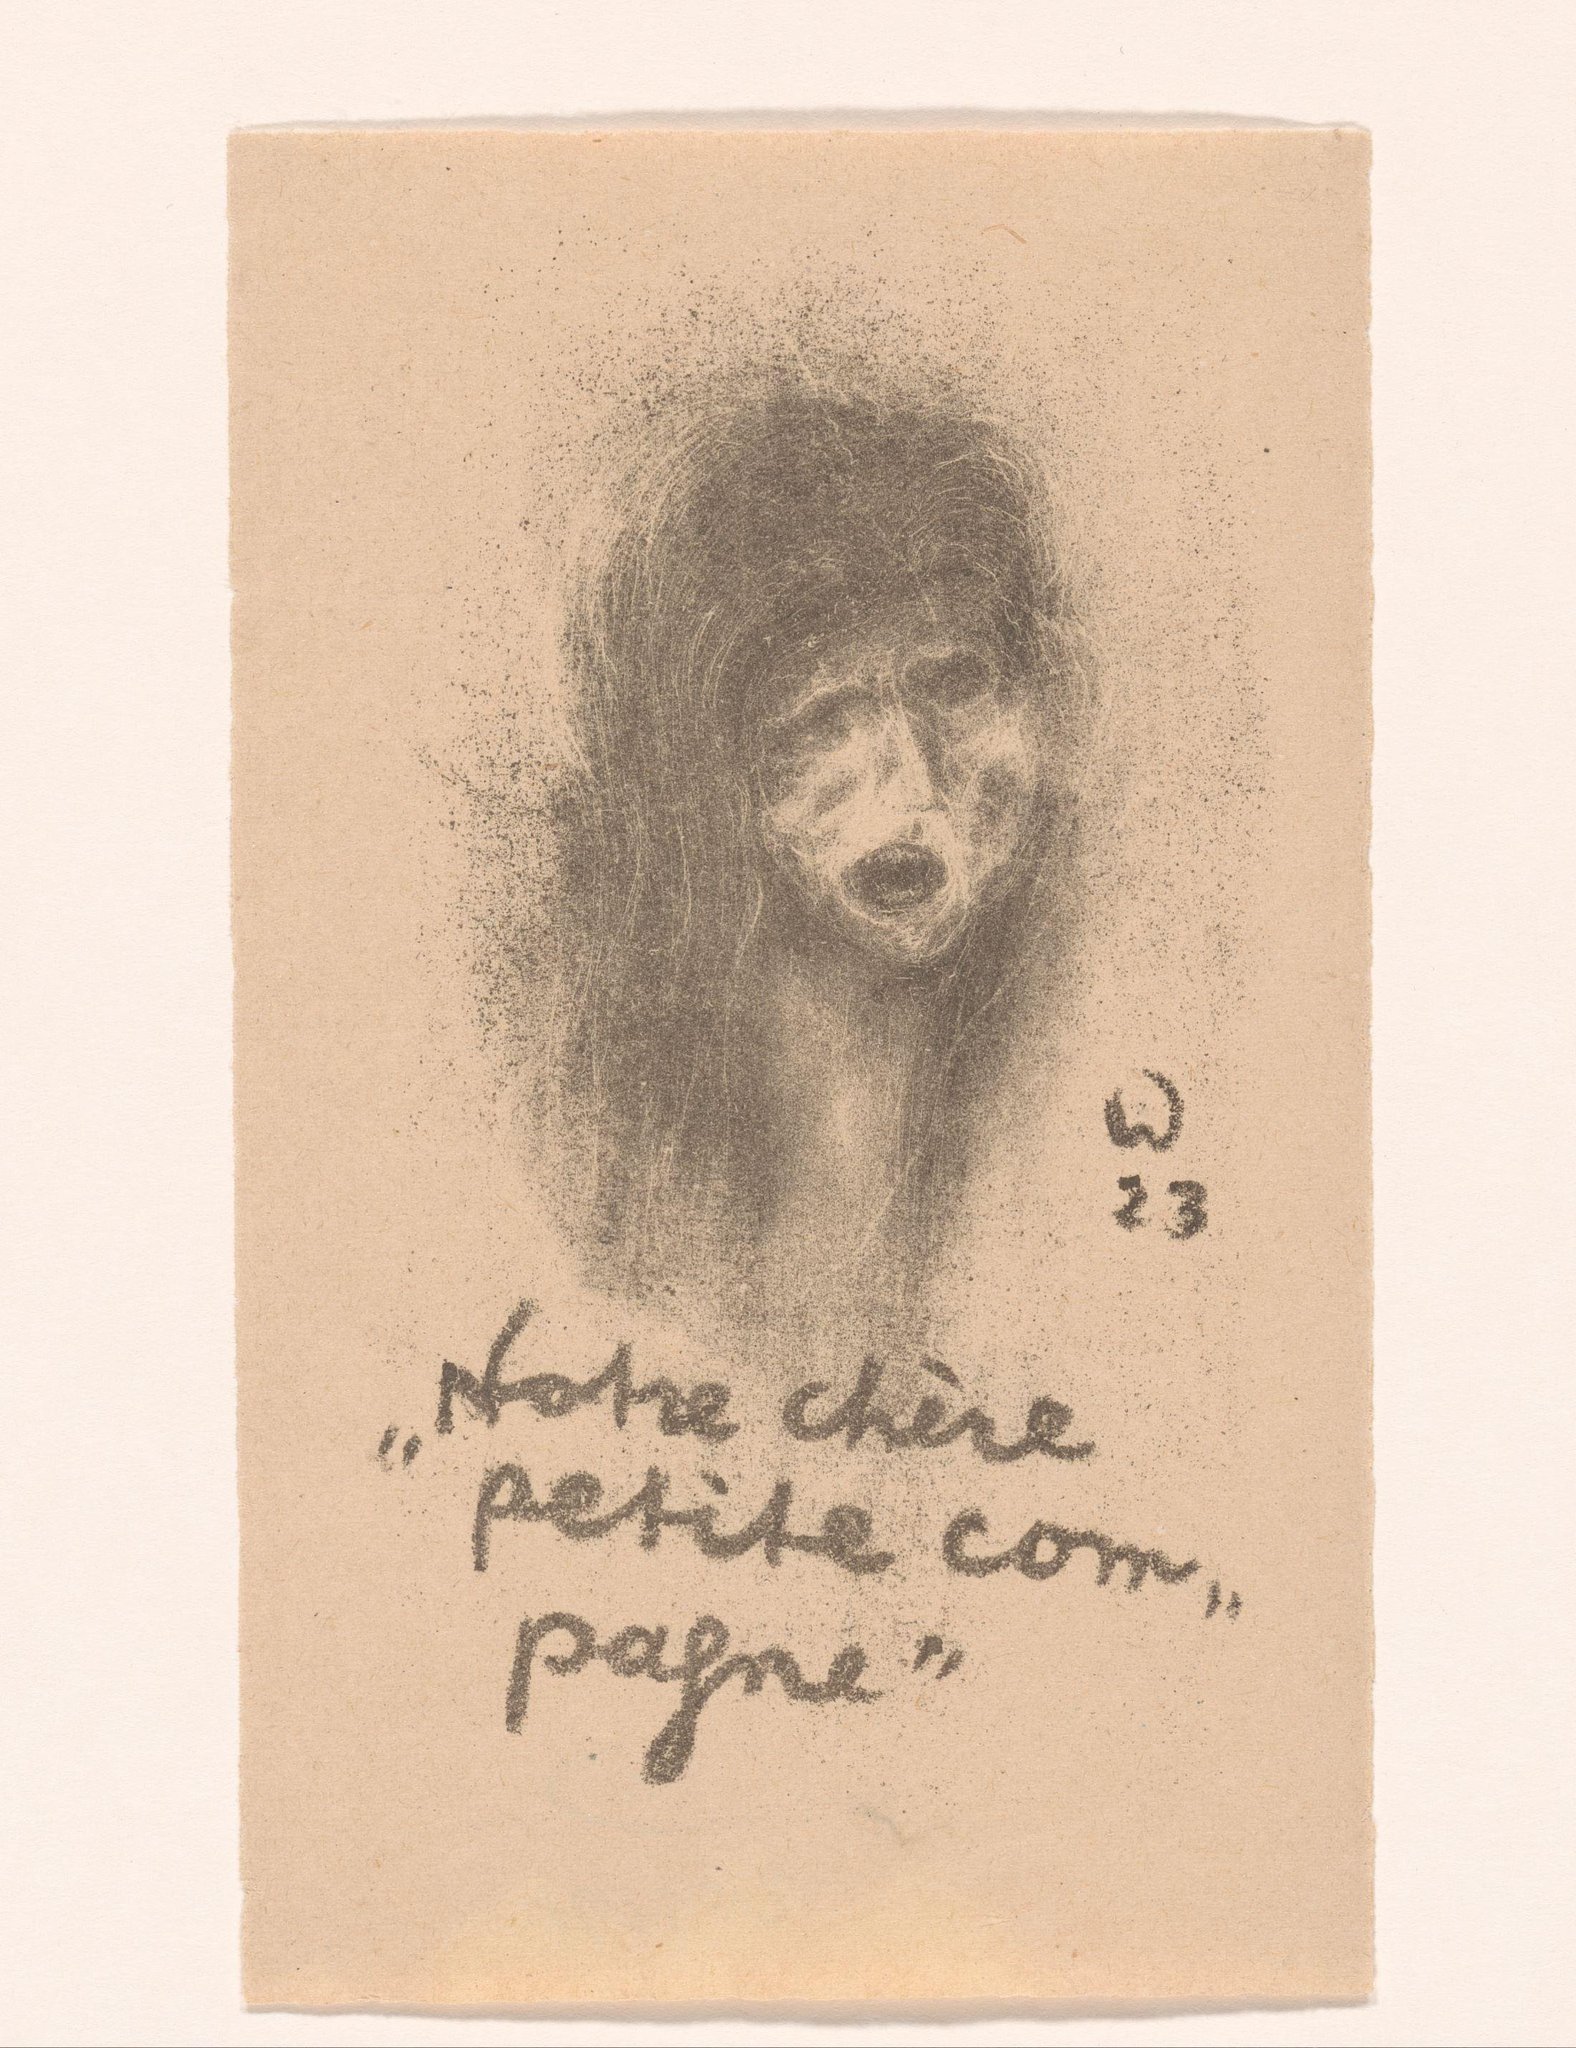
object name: print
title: Notre chère petite compagne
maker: erich wichmann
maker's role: print maker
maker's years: 1890-1929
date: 1923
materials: paper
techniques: lithograph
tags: caricatures (human types)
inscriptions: collector's mark: Lugt 2228